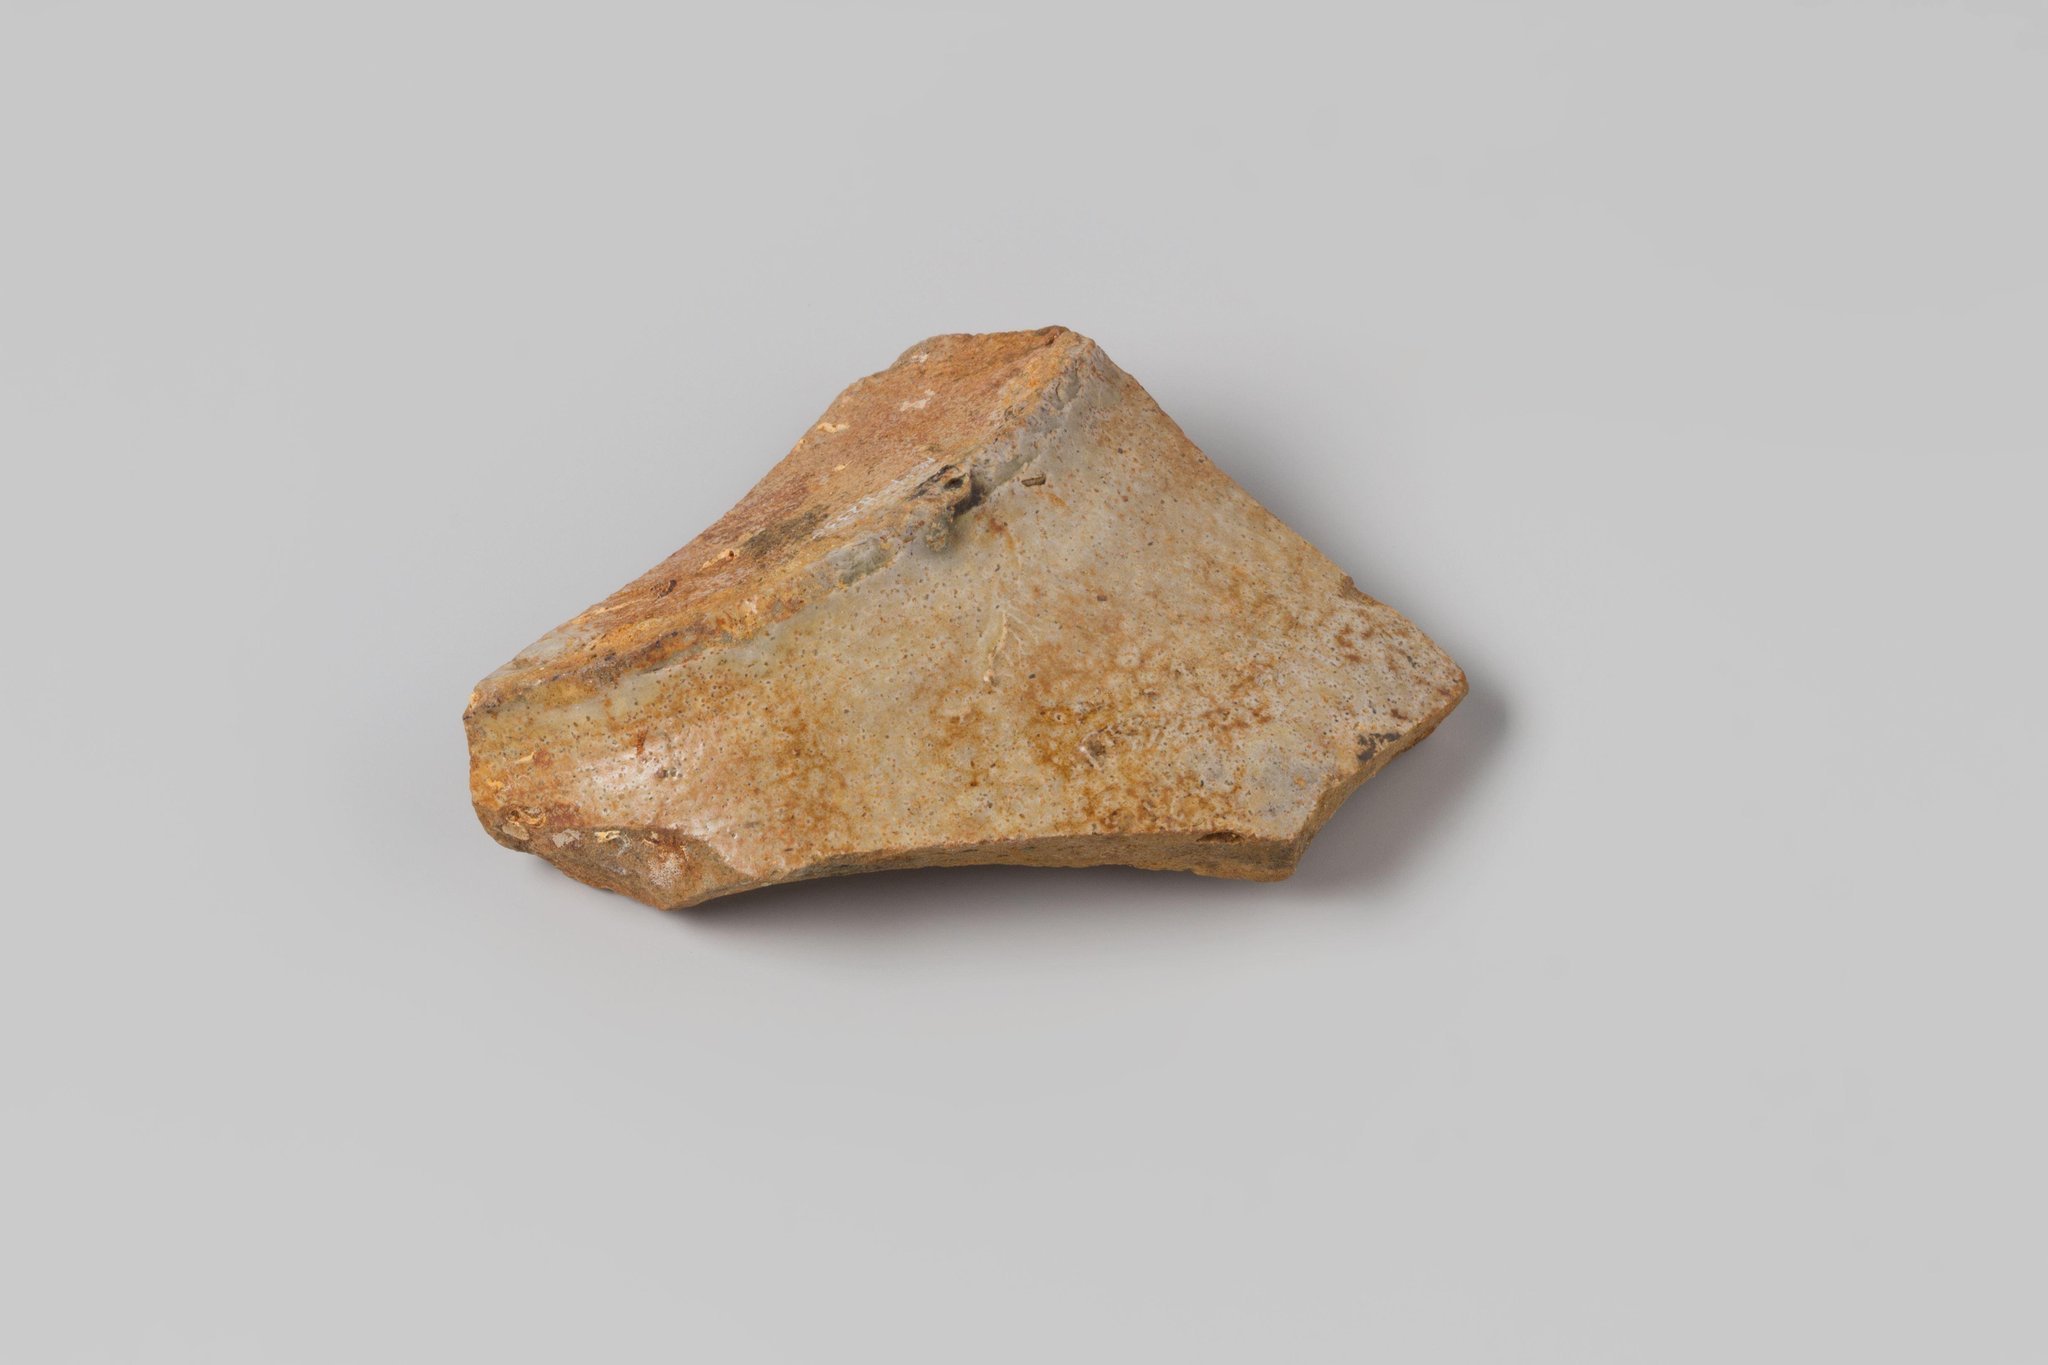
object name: sherd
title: Scherf van een kan uit het wrak van de Oost-Indiëvaarder Hollandia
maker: Anonymous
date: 1700-1743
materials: stoneware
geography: cologne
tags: verenigde oostindische compagnie, hollandia (schip), annet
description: Stoneware, Rhenish, Frechen-ware, jug; fragm of base.